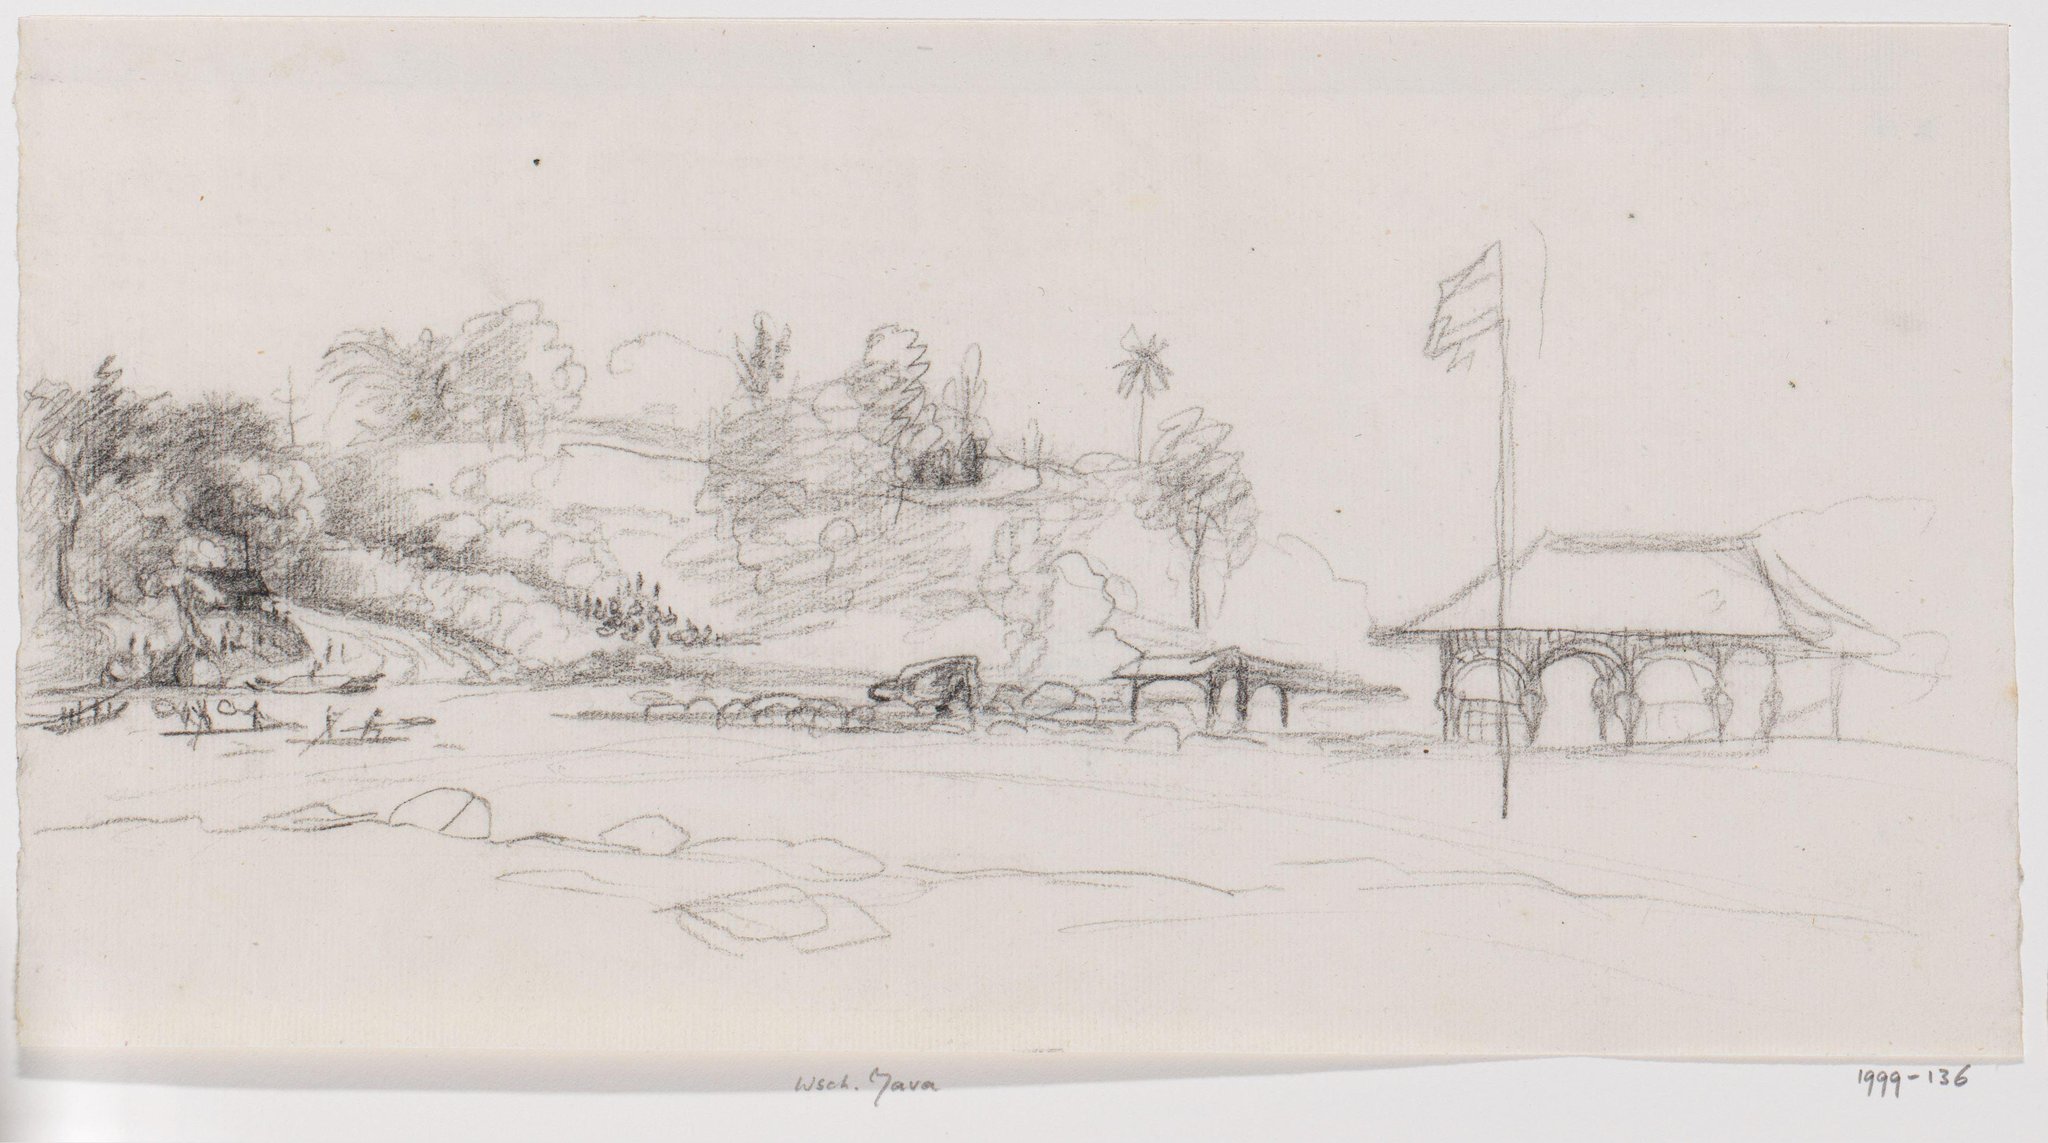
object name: drawing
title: Rivierlandschap, Java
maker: adrianus johannes bik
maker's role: draughtsman, print maker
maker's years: 1790-1872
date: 1816-1846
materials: chalk, paper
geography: java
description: artikel over deze collectie in Bulletin van het Rijksmuseum 49 [2001], nr. 4, pp 342 e.v., p. 352, afb. 10